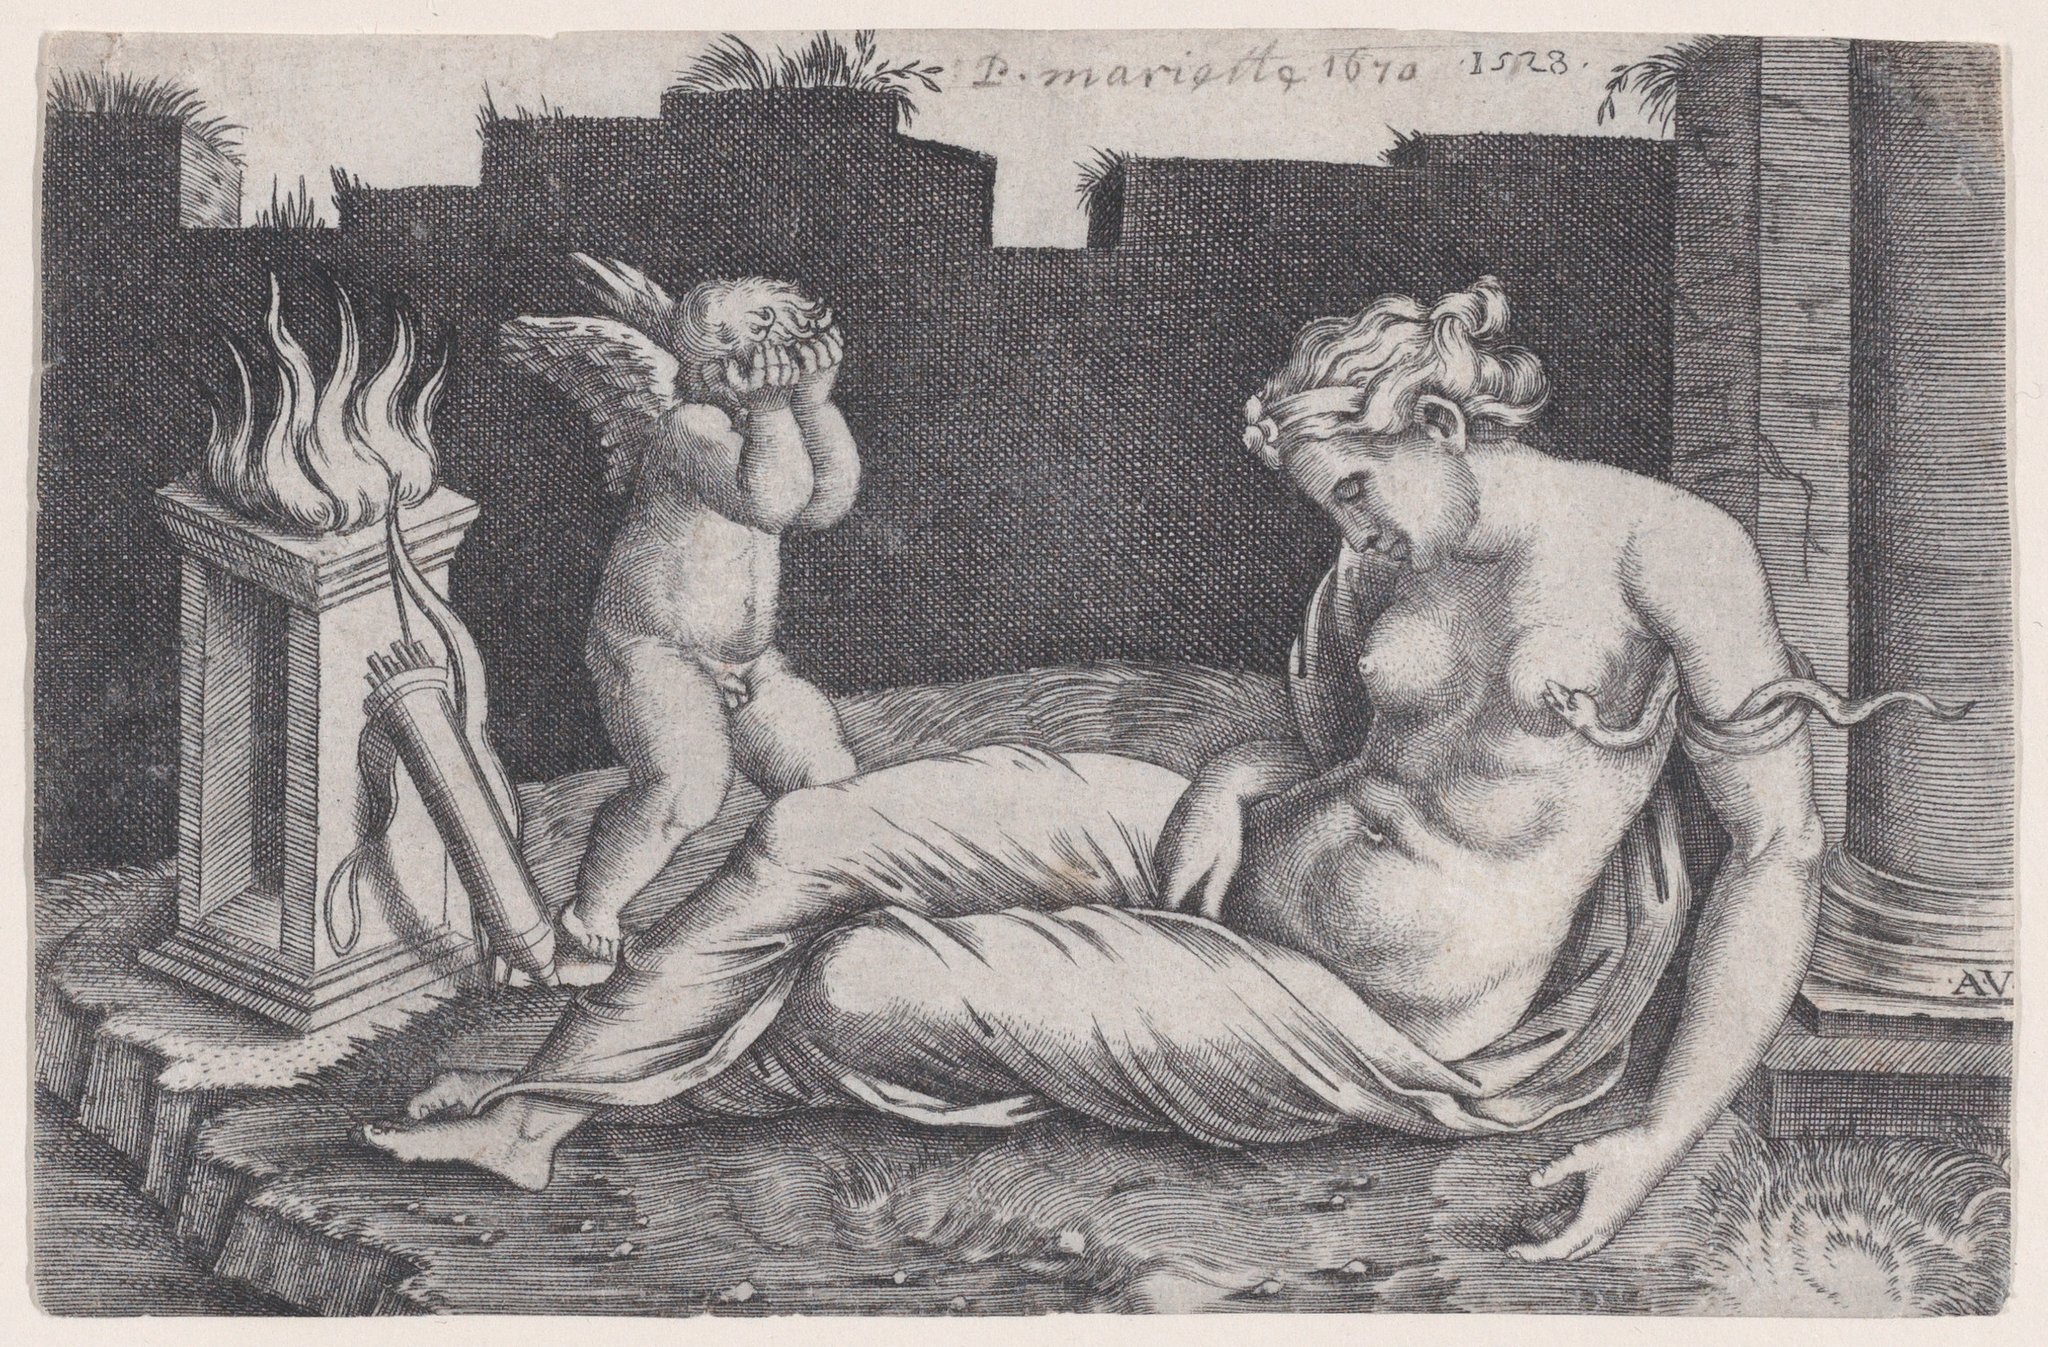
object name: print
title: Cleopatra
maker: agostino veneziano (agostino dei musi)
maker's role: artist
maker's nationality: italian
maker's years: 1490-1536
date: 1528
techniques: engraving